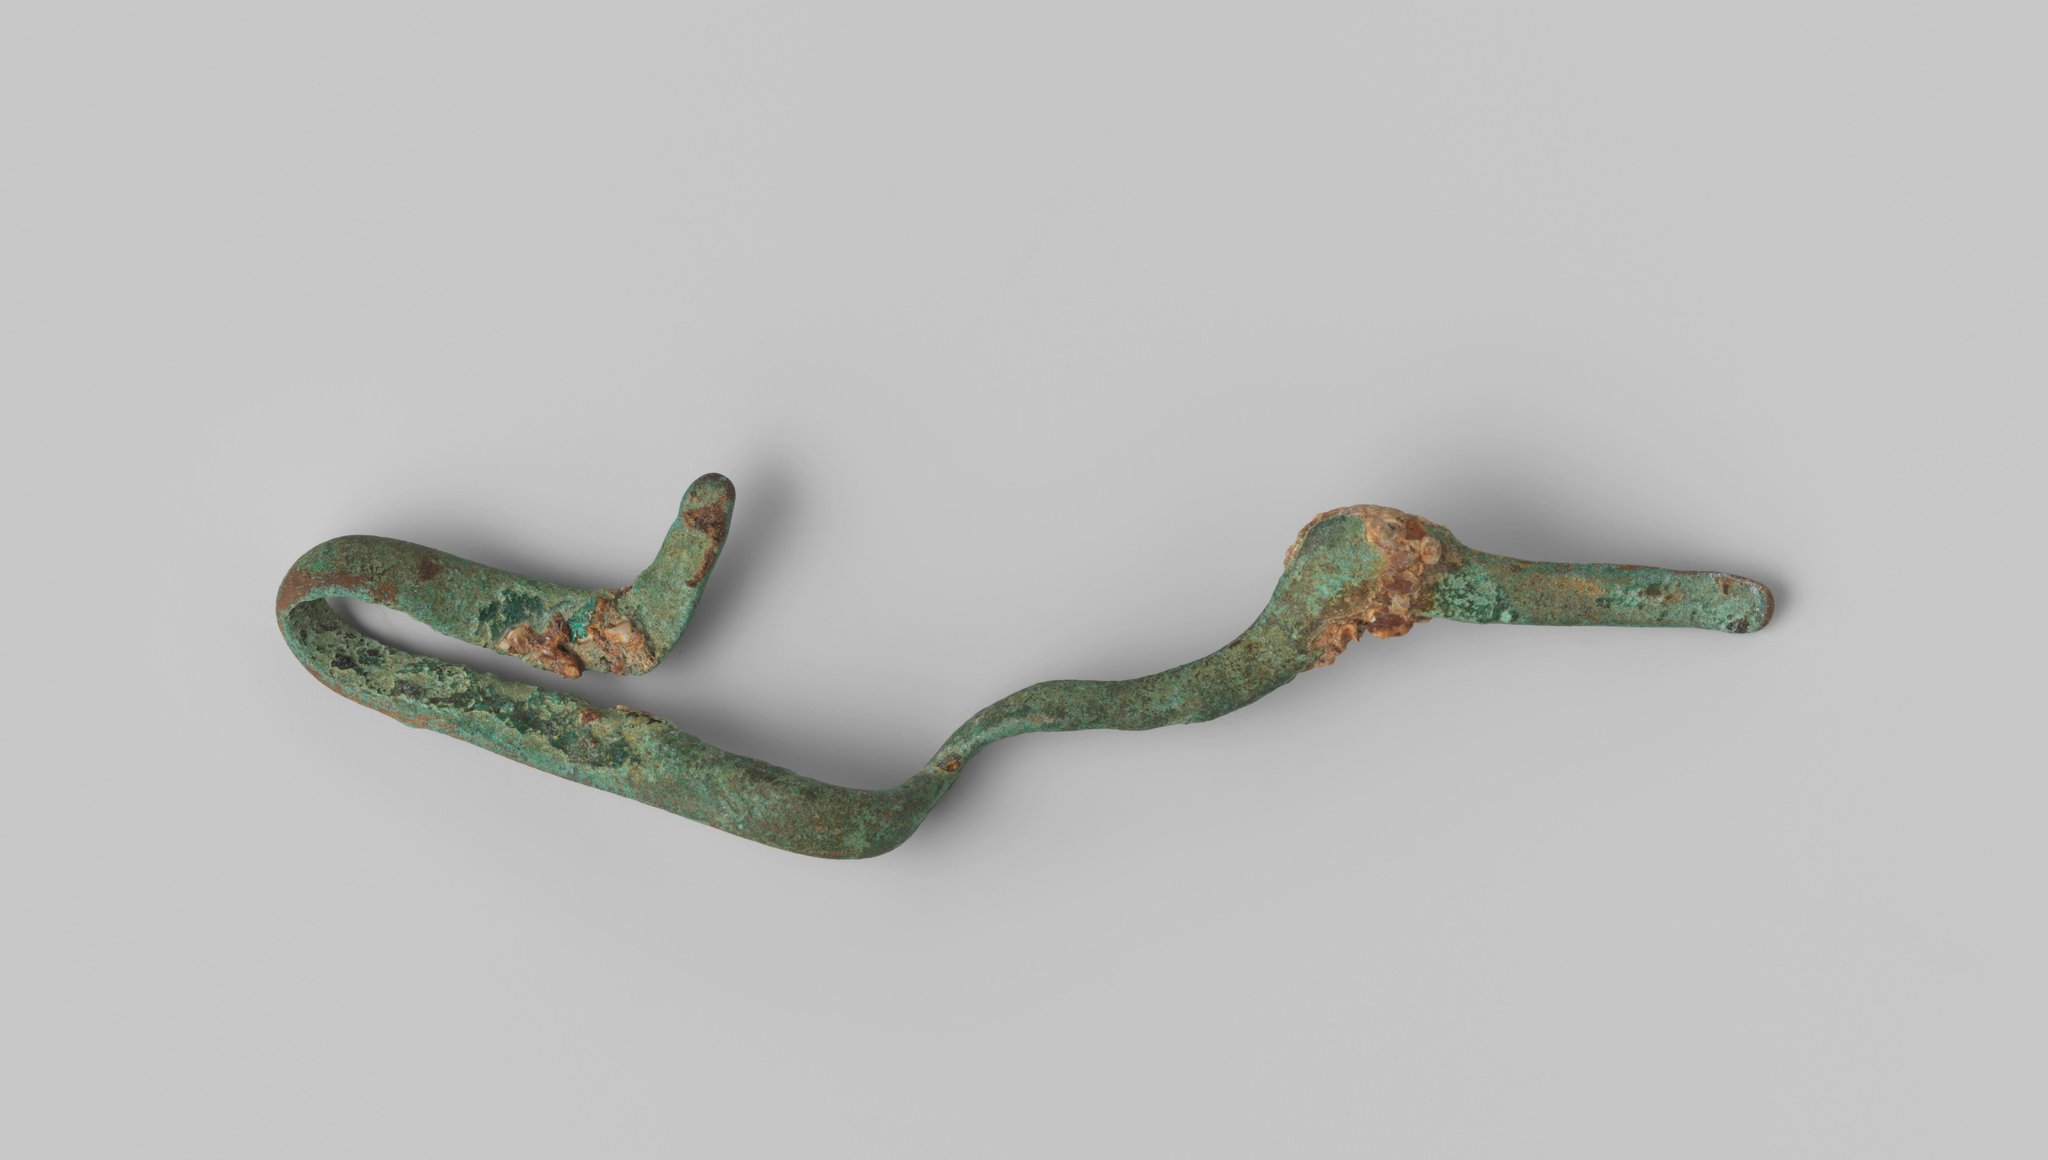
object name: belt buckle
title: Fragment riemgesp uit het wrak van de Oost-Indiëvaarder Hollandia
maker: Anonymous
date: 1700-1743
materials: copper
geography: netherlands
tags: verenigde oostindische compagnie, hollandia (schip), annet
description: Rectangular, fragm of ring, id. NG 1980-27H2796, belt buckle.